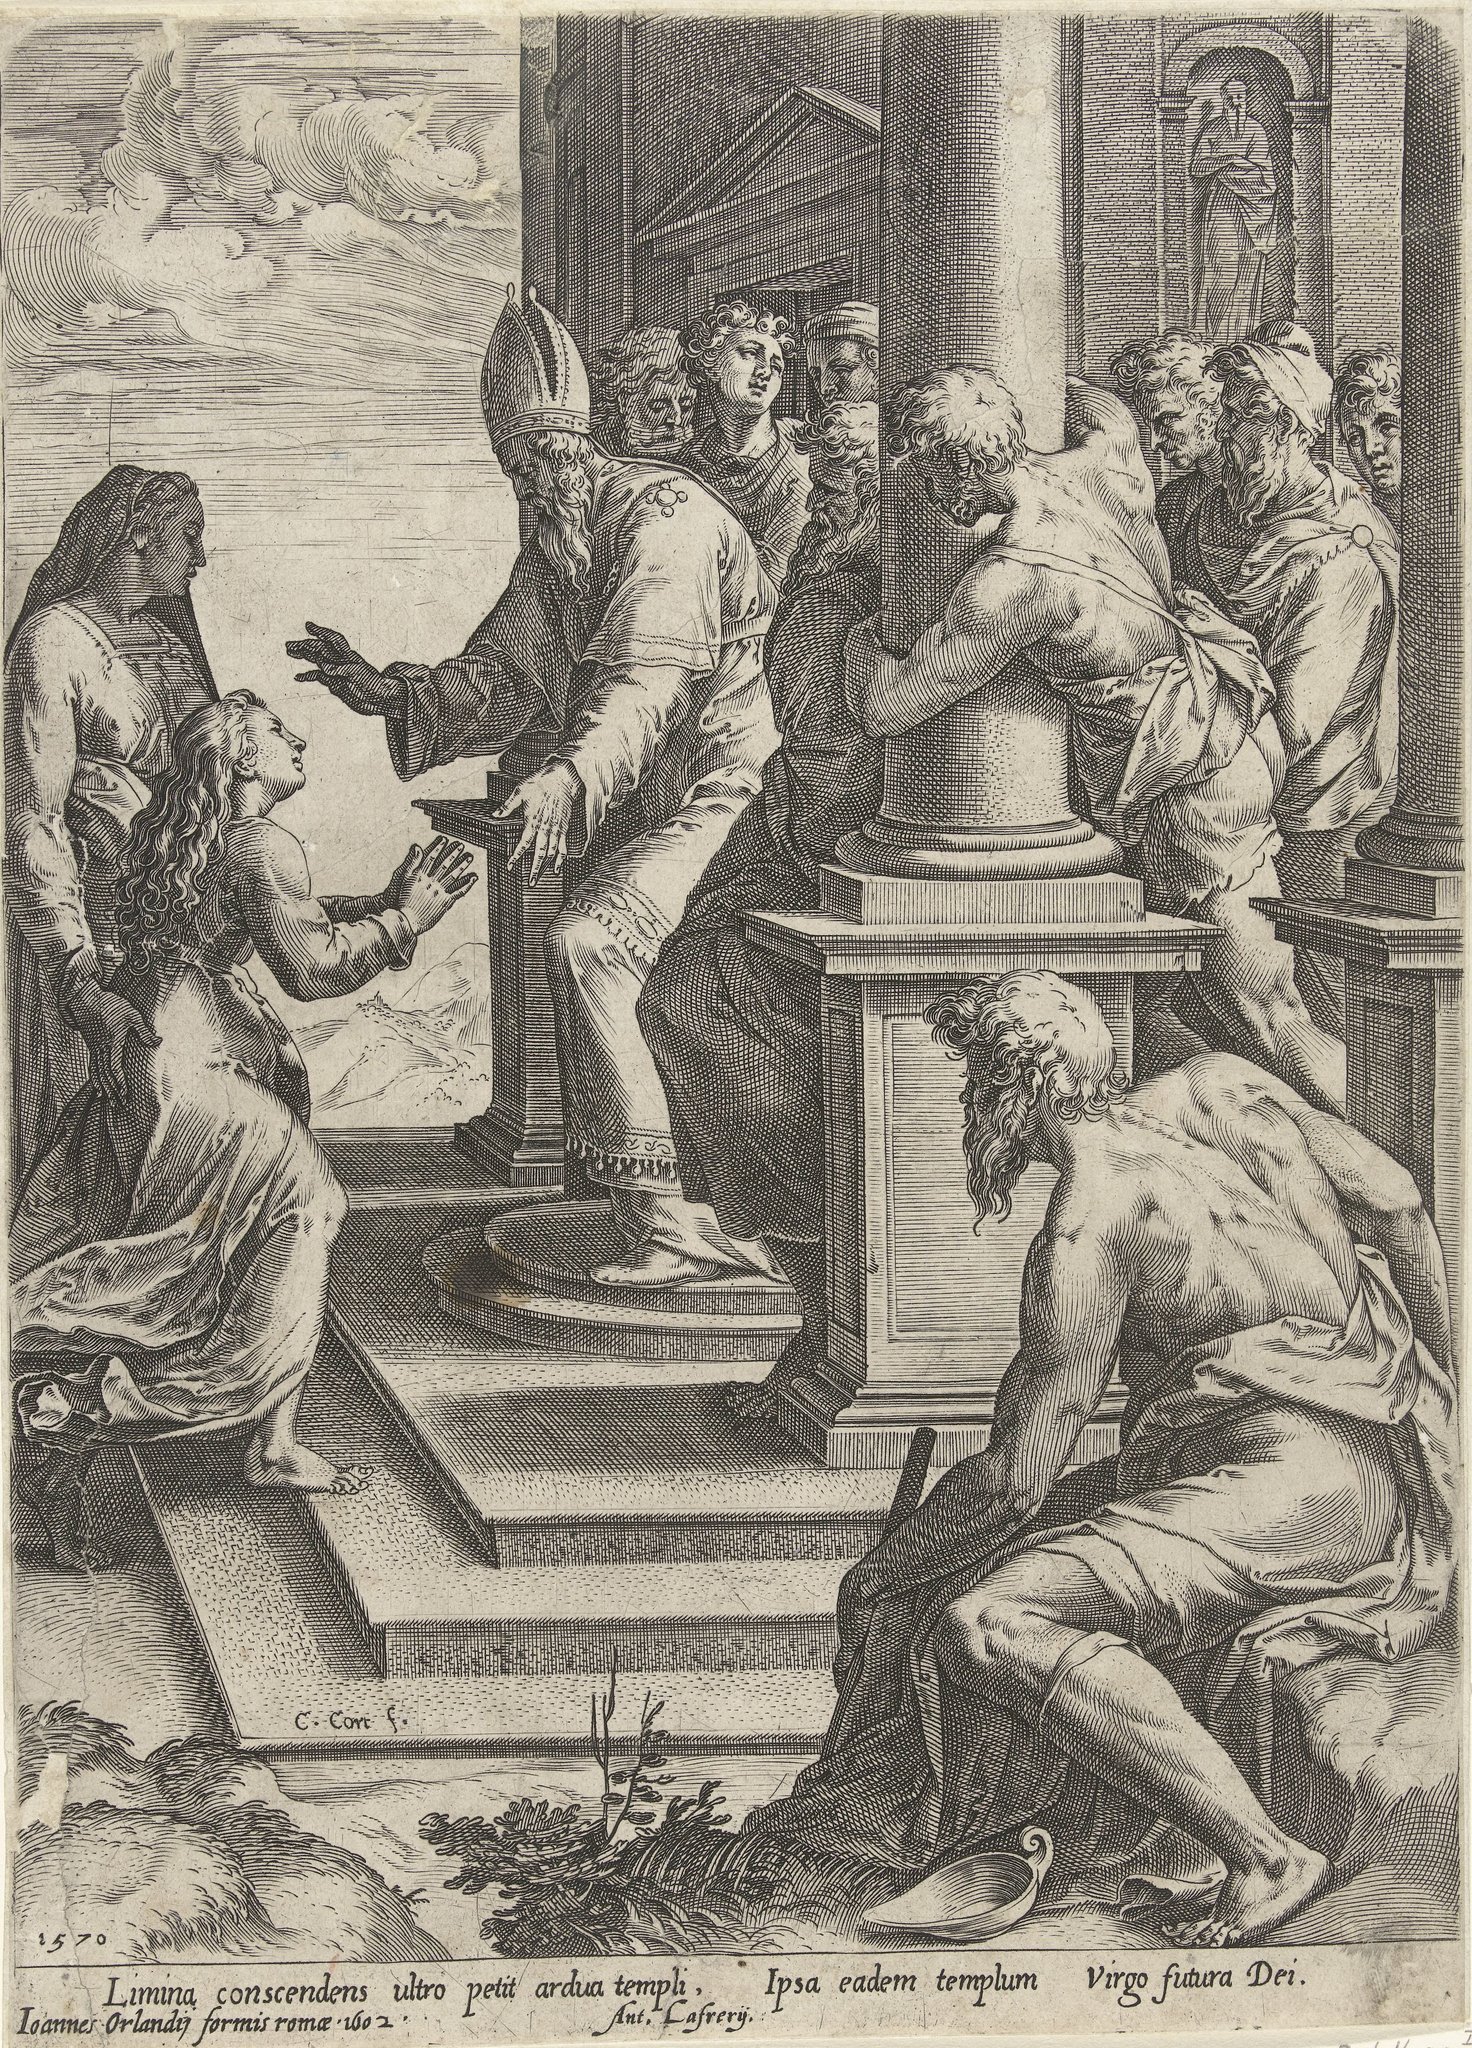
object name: print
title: Presentatie van Maria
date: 1602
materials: paper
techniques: engraving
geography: rome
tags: dedication (or presentation) of mary in the temple: she ascends the steps and is received by the high priest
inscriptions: collector's mark: Lugt 2228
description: Maria wordt door haar moeder Anna begeleidt naar de tempel. Voor de deur van de tempel wordt zij opgewacht door de hogepriester Zacharias.